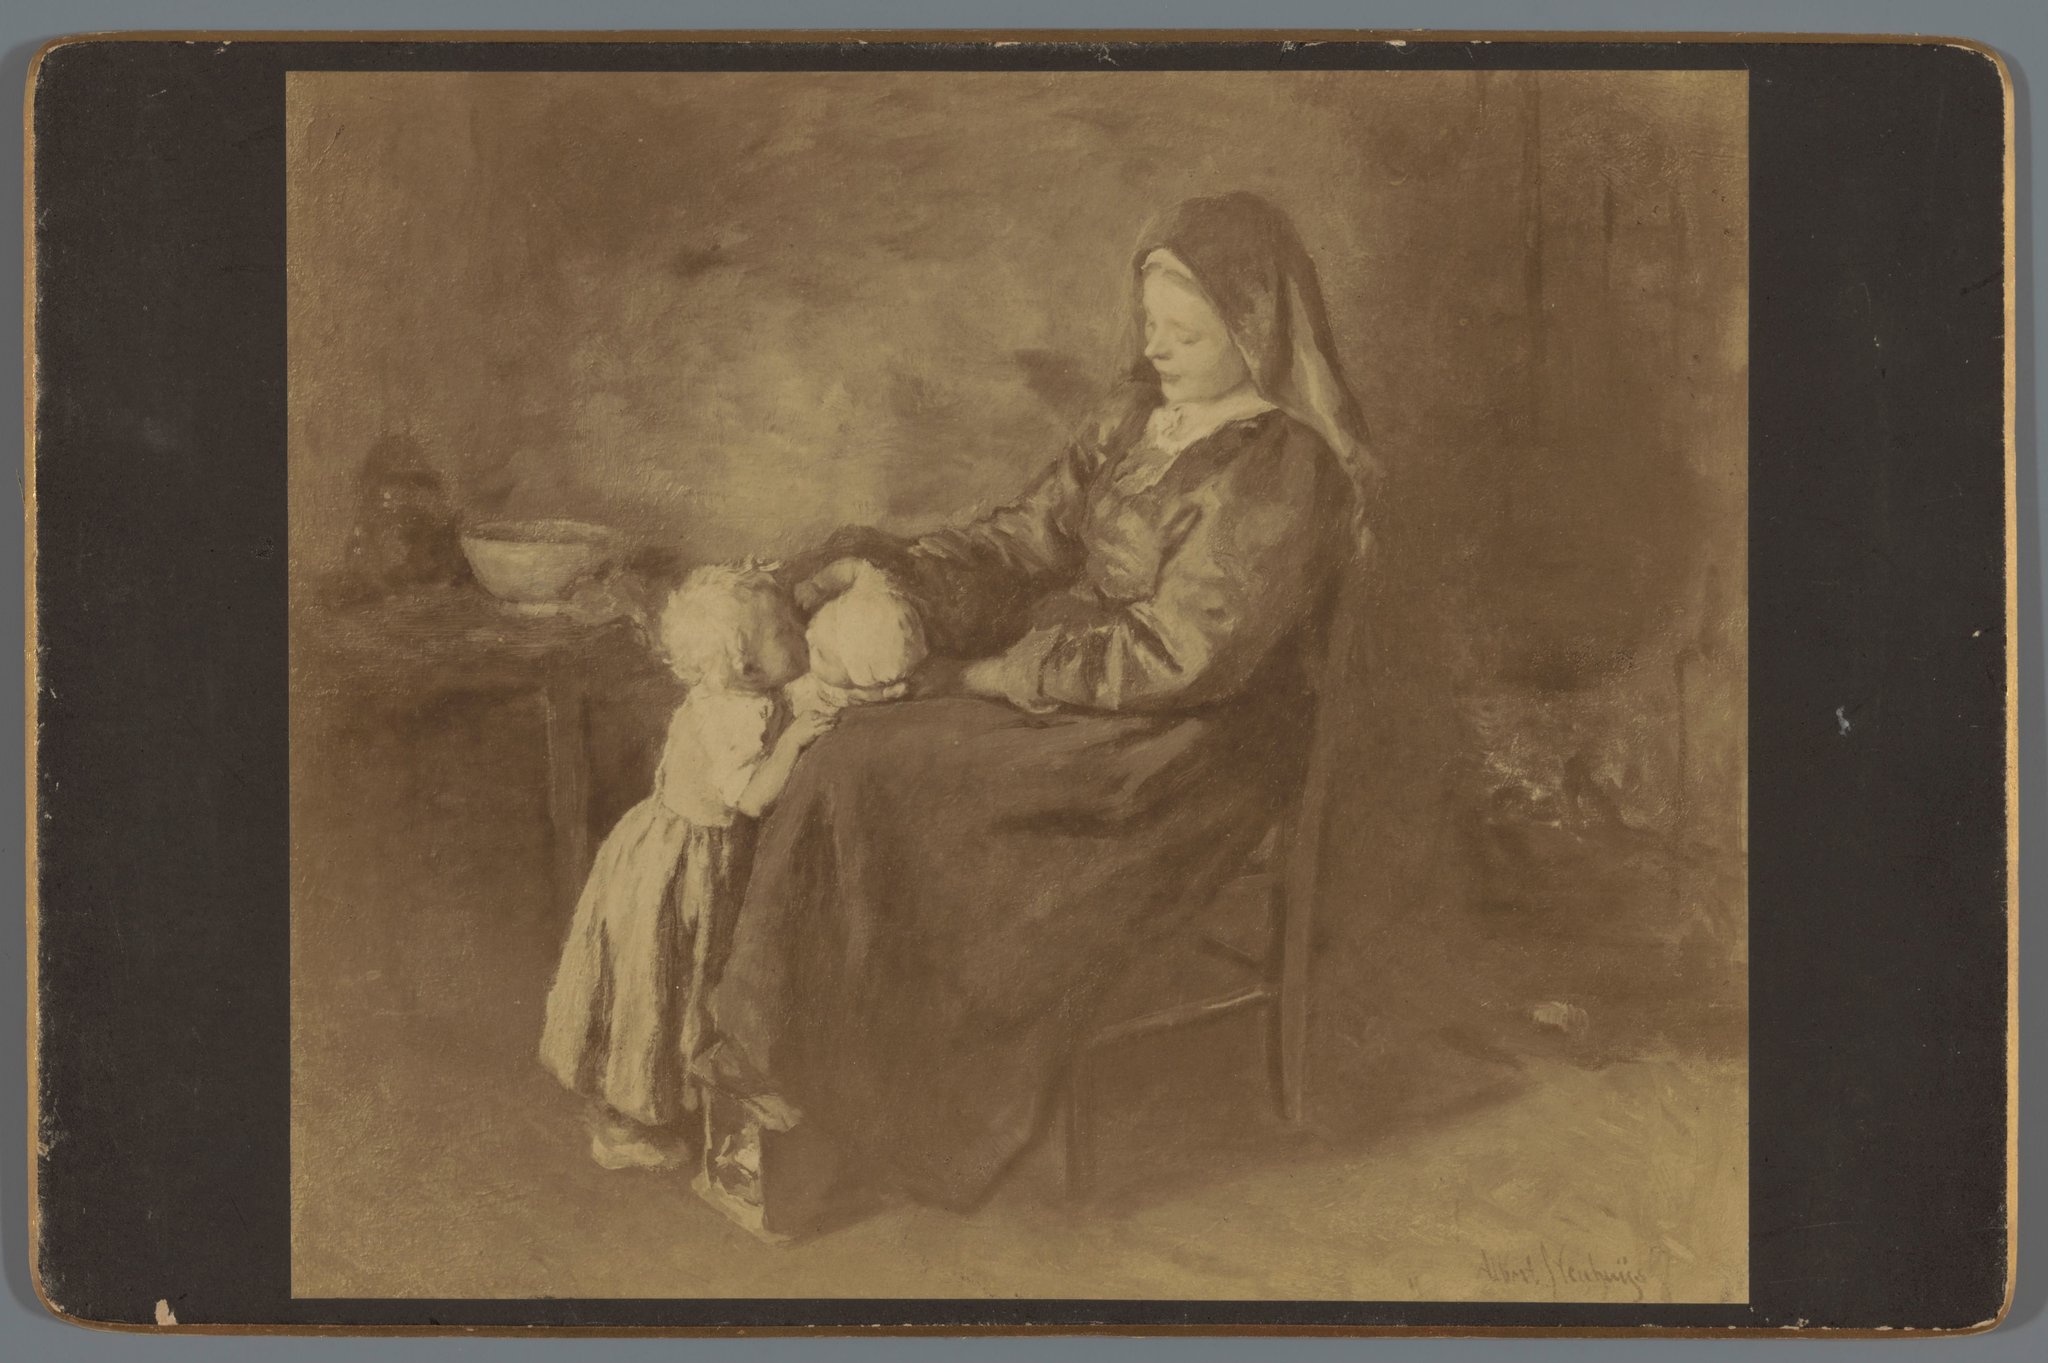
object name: photograph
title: Fotoreproductie van schilderij door Albert Neuhuys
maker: Anonymous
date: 1850-1900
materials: cardboard, photographic support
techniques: albumen print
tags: adult woman, child, infant, baby